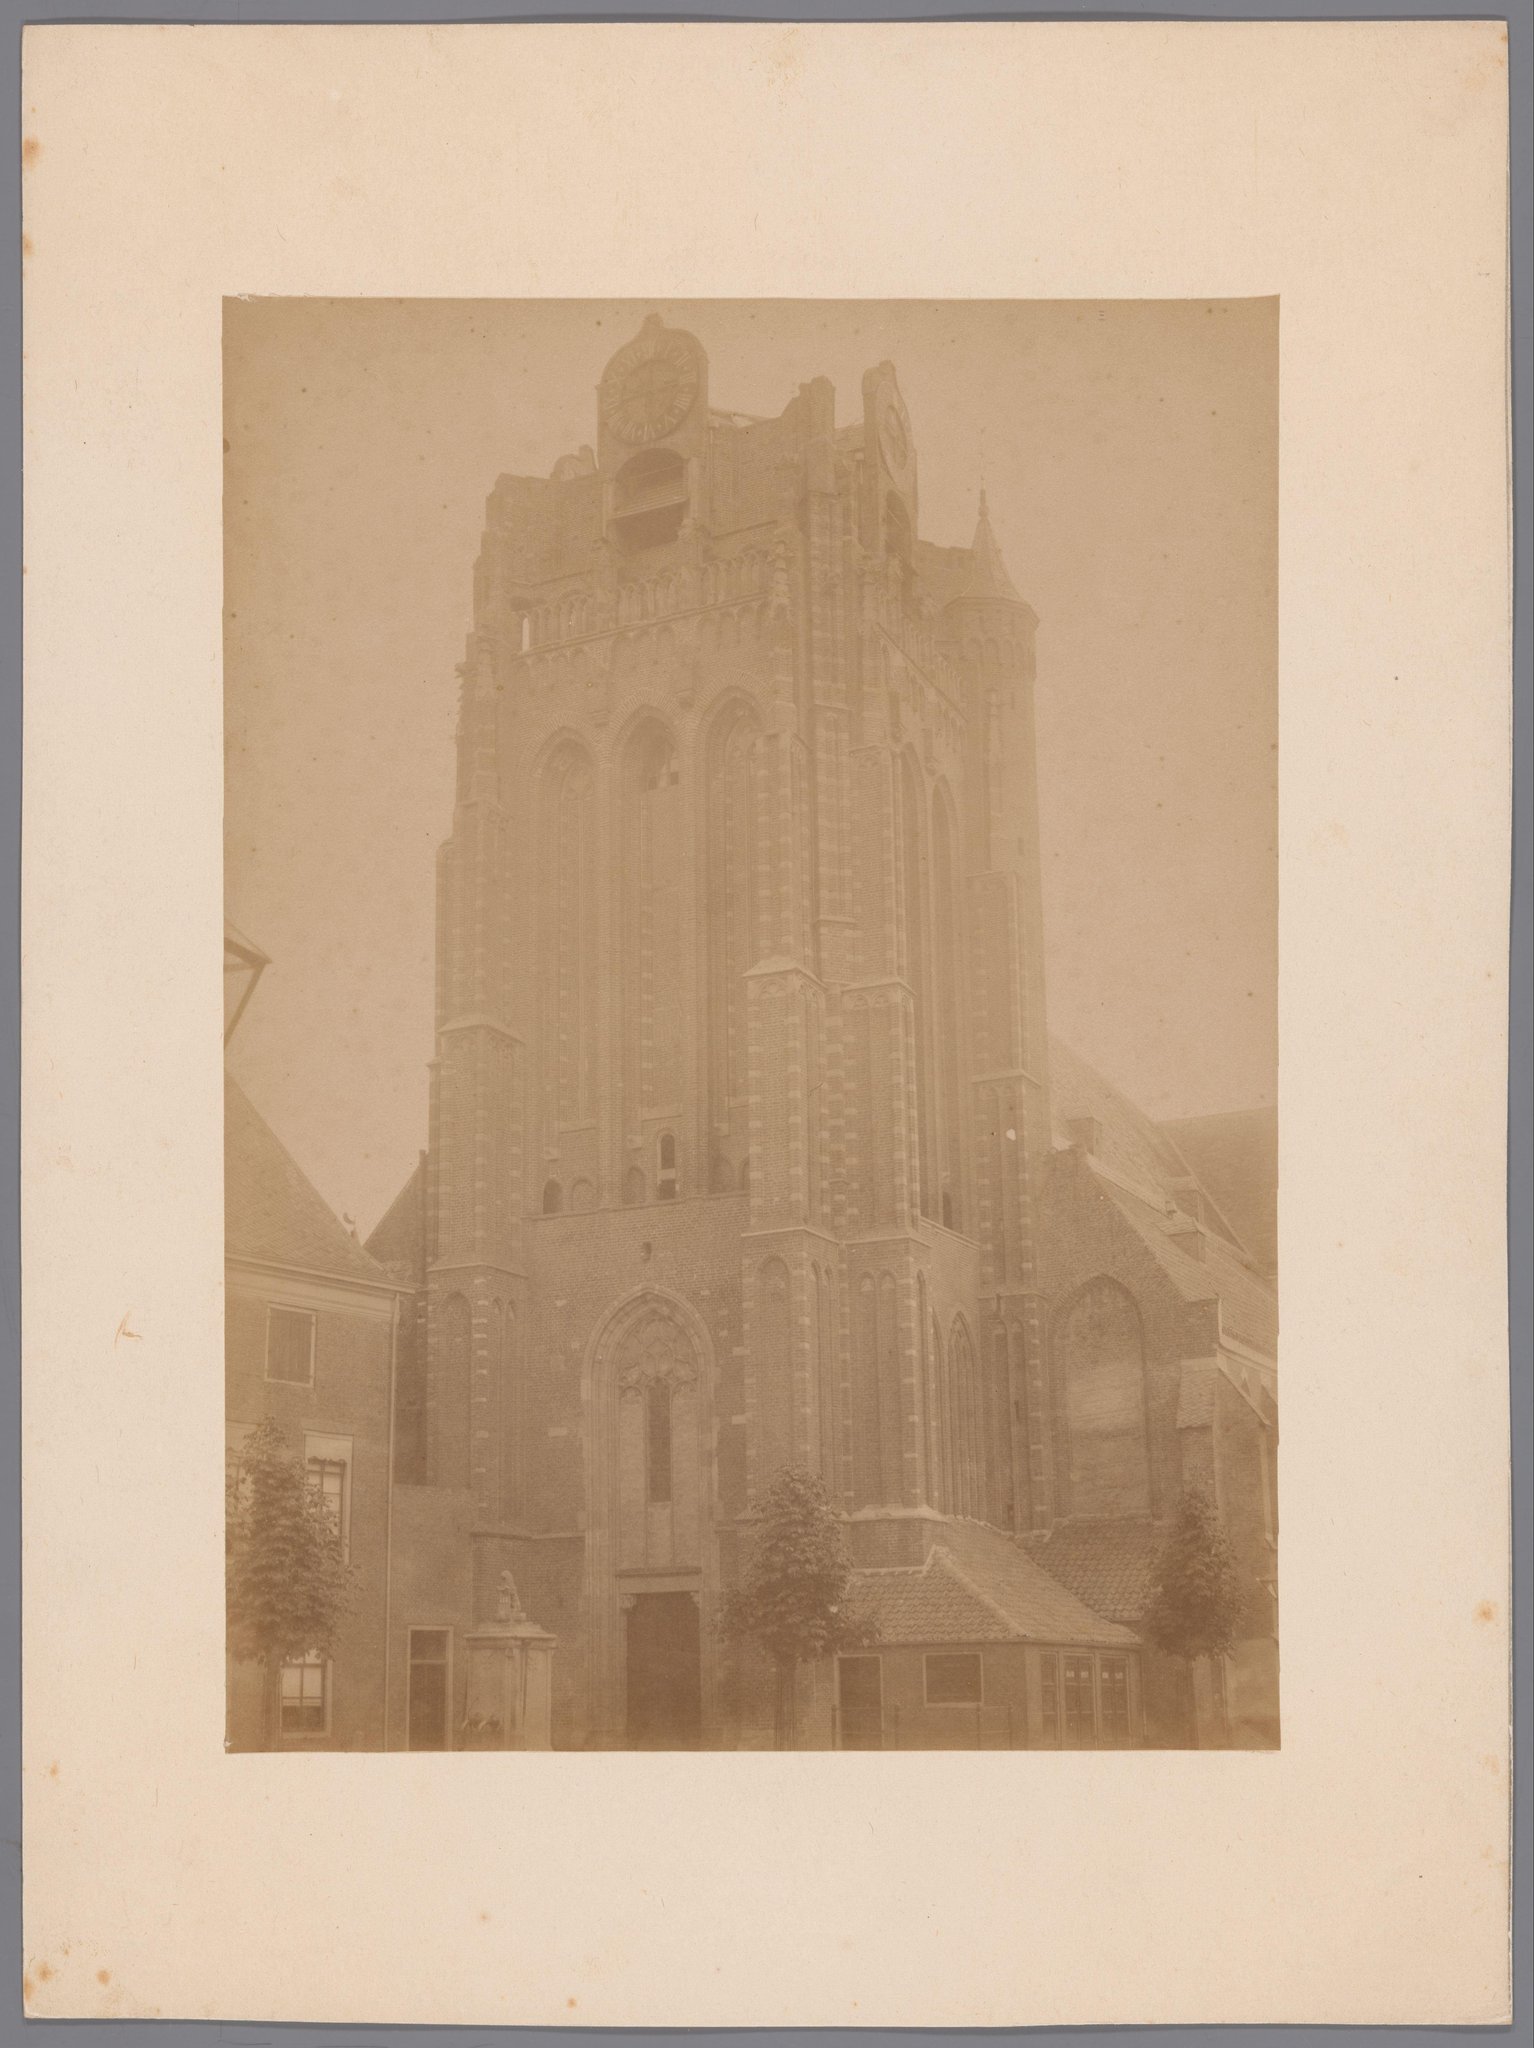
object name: photograph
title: Toren van de Grote of Johannes de Doperkerk te Wijk bij Duurstede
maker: anoniem (monumentenzorg)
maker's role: fotograaf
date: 1892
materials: cardboard, photographic support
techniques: albumen print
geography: wijk bij duurstede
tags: parts of church exterior and annexes: tower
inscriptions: annotation: ‘Toren te Wijk-bij-Duurstede (U.)/ genomen van af den kerk/ sept 1892’